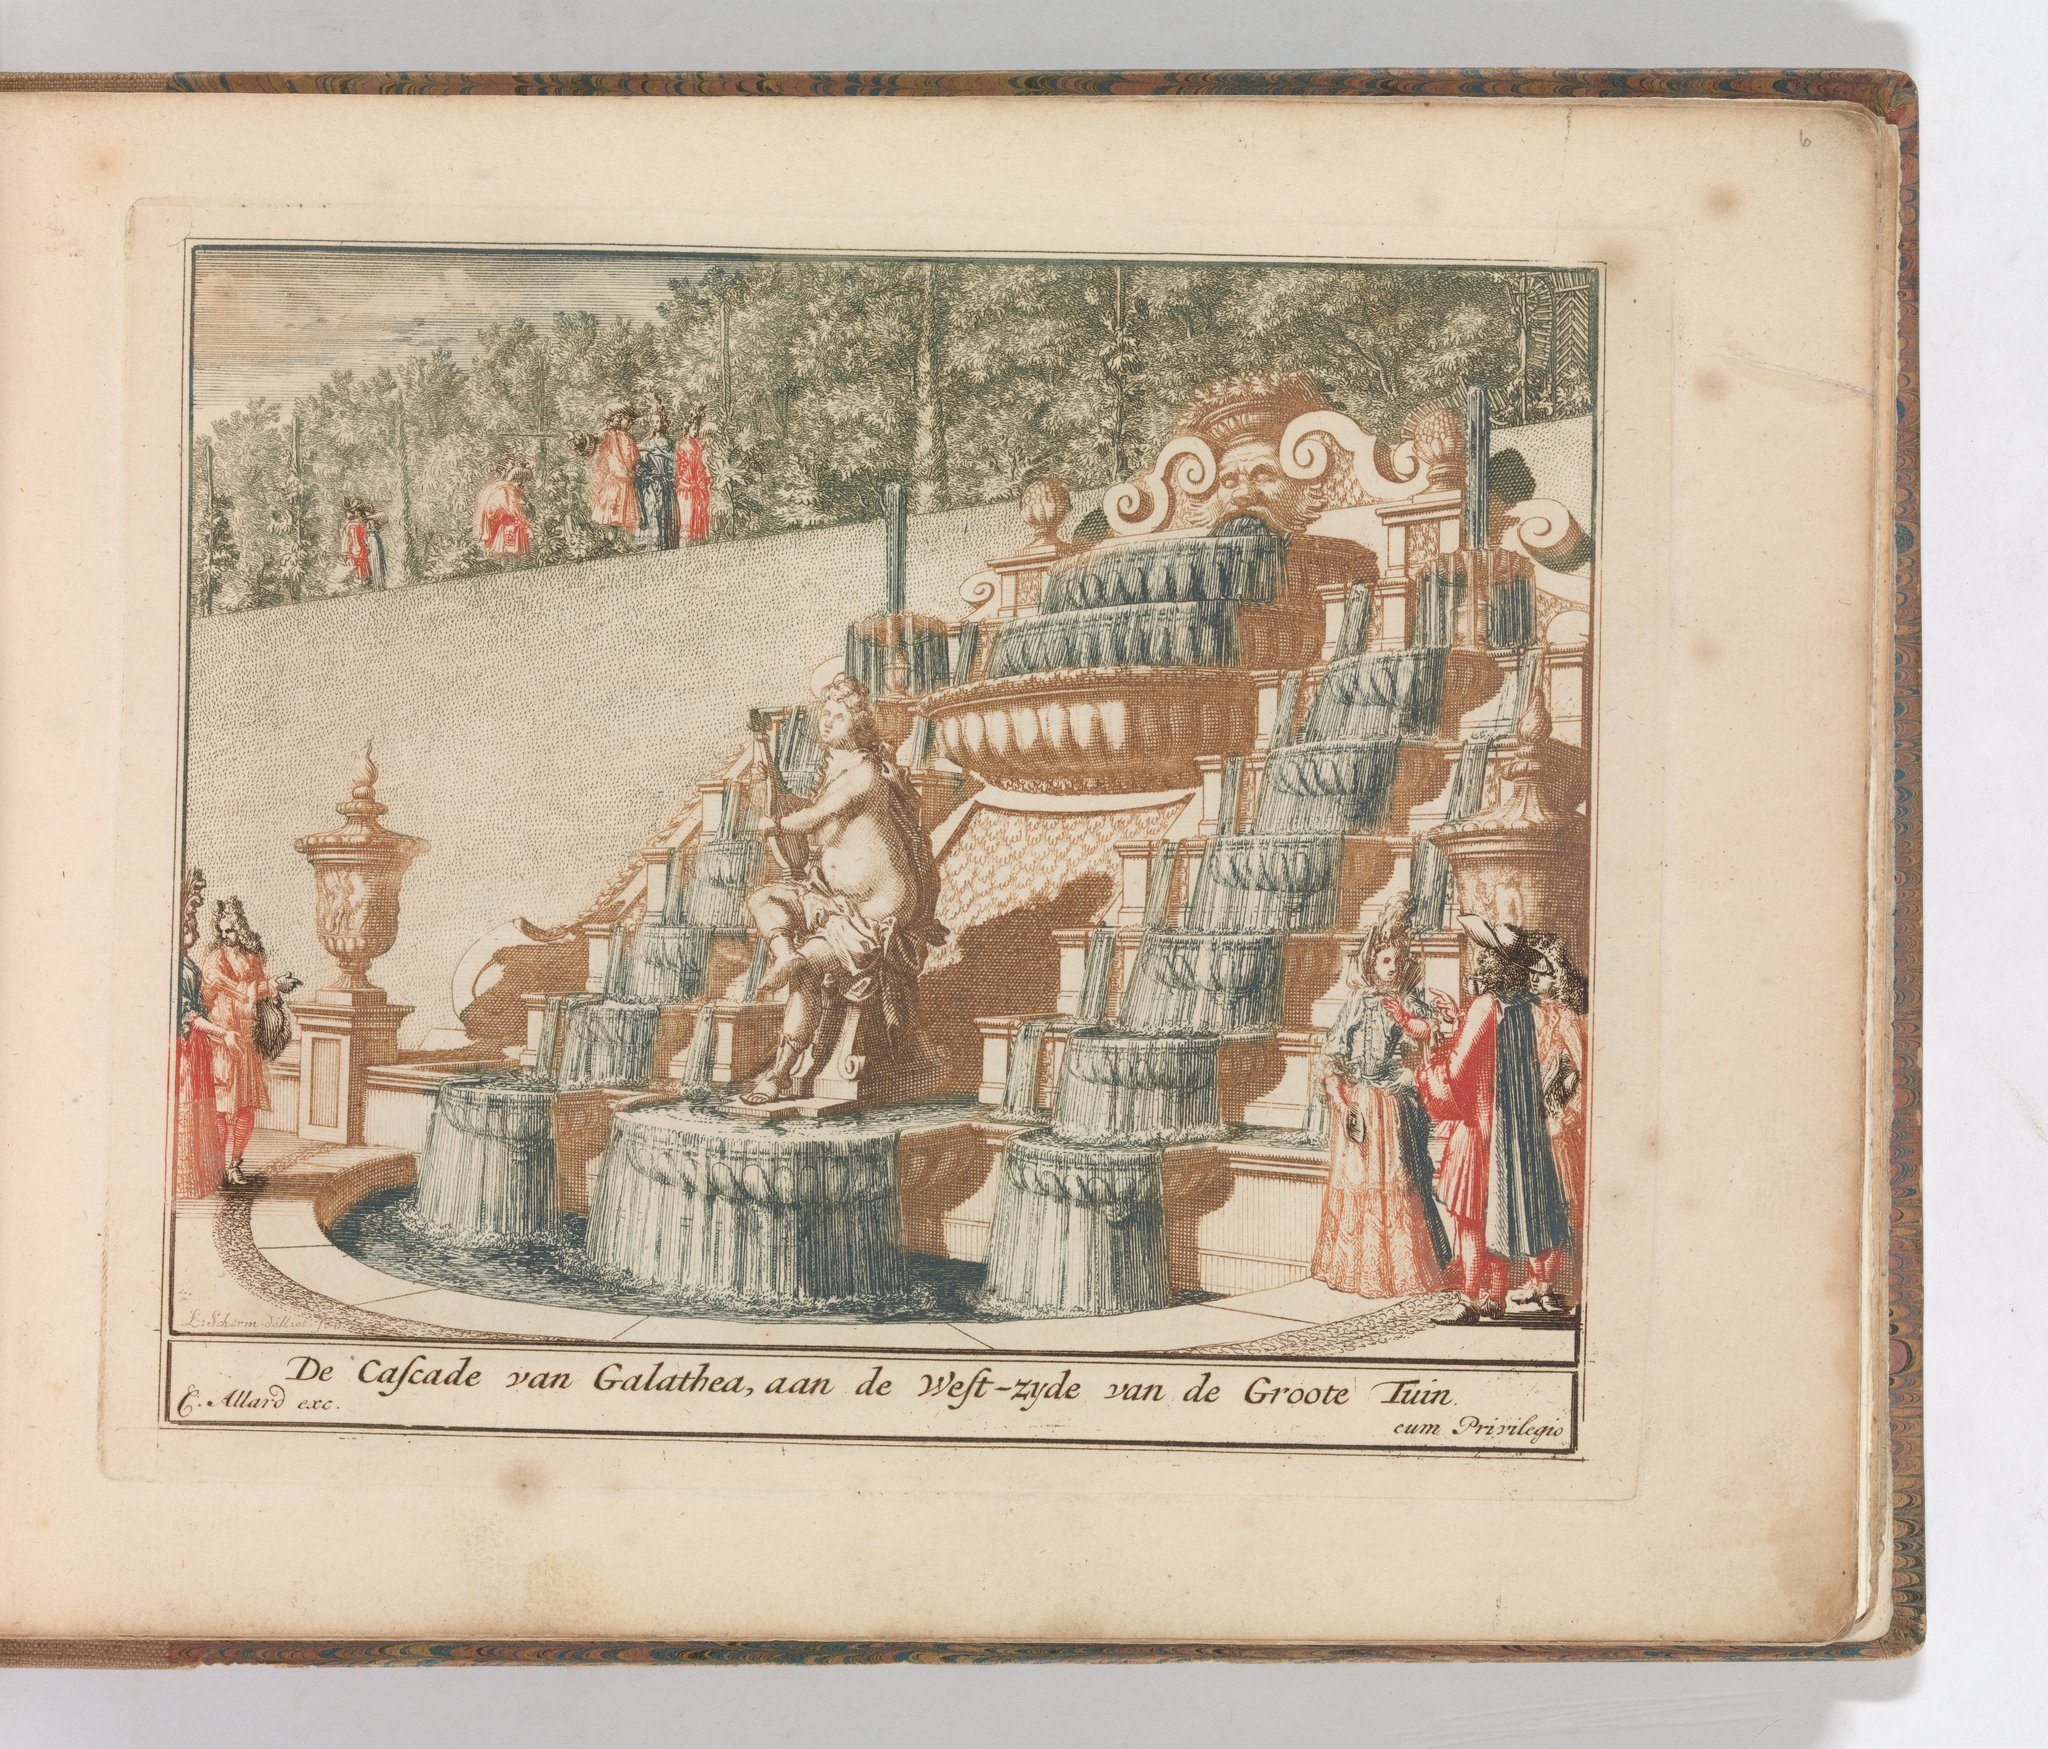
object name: book print ornament architecture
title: 'De Cascade van Galathea, aan de West-zyde van de Groote Tuin', in: Tooneel Der Voornaamste Nederlands Huizen, En Lust Hoven, Naar T Leven Afgebeeld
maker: carel allard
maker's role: publisher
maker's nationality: dutch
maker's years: 1648-1709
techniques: engraving, lithography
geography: amsterdam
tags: fountains,gardens,men,women